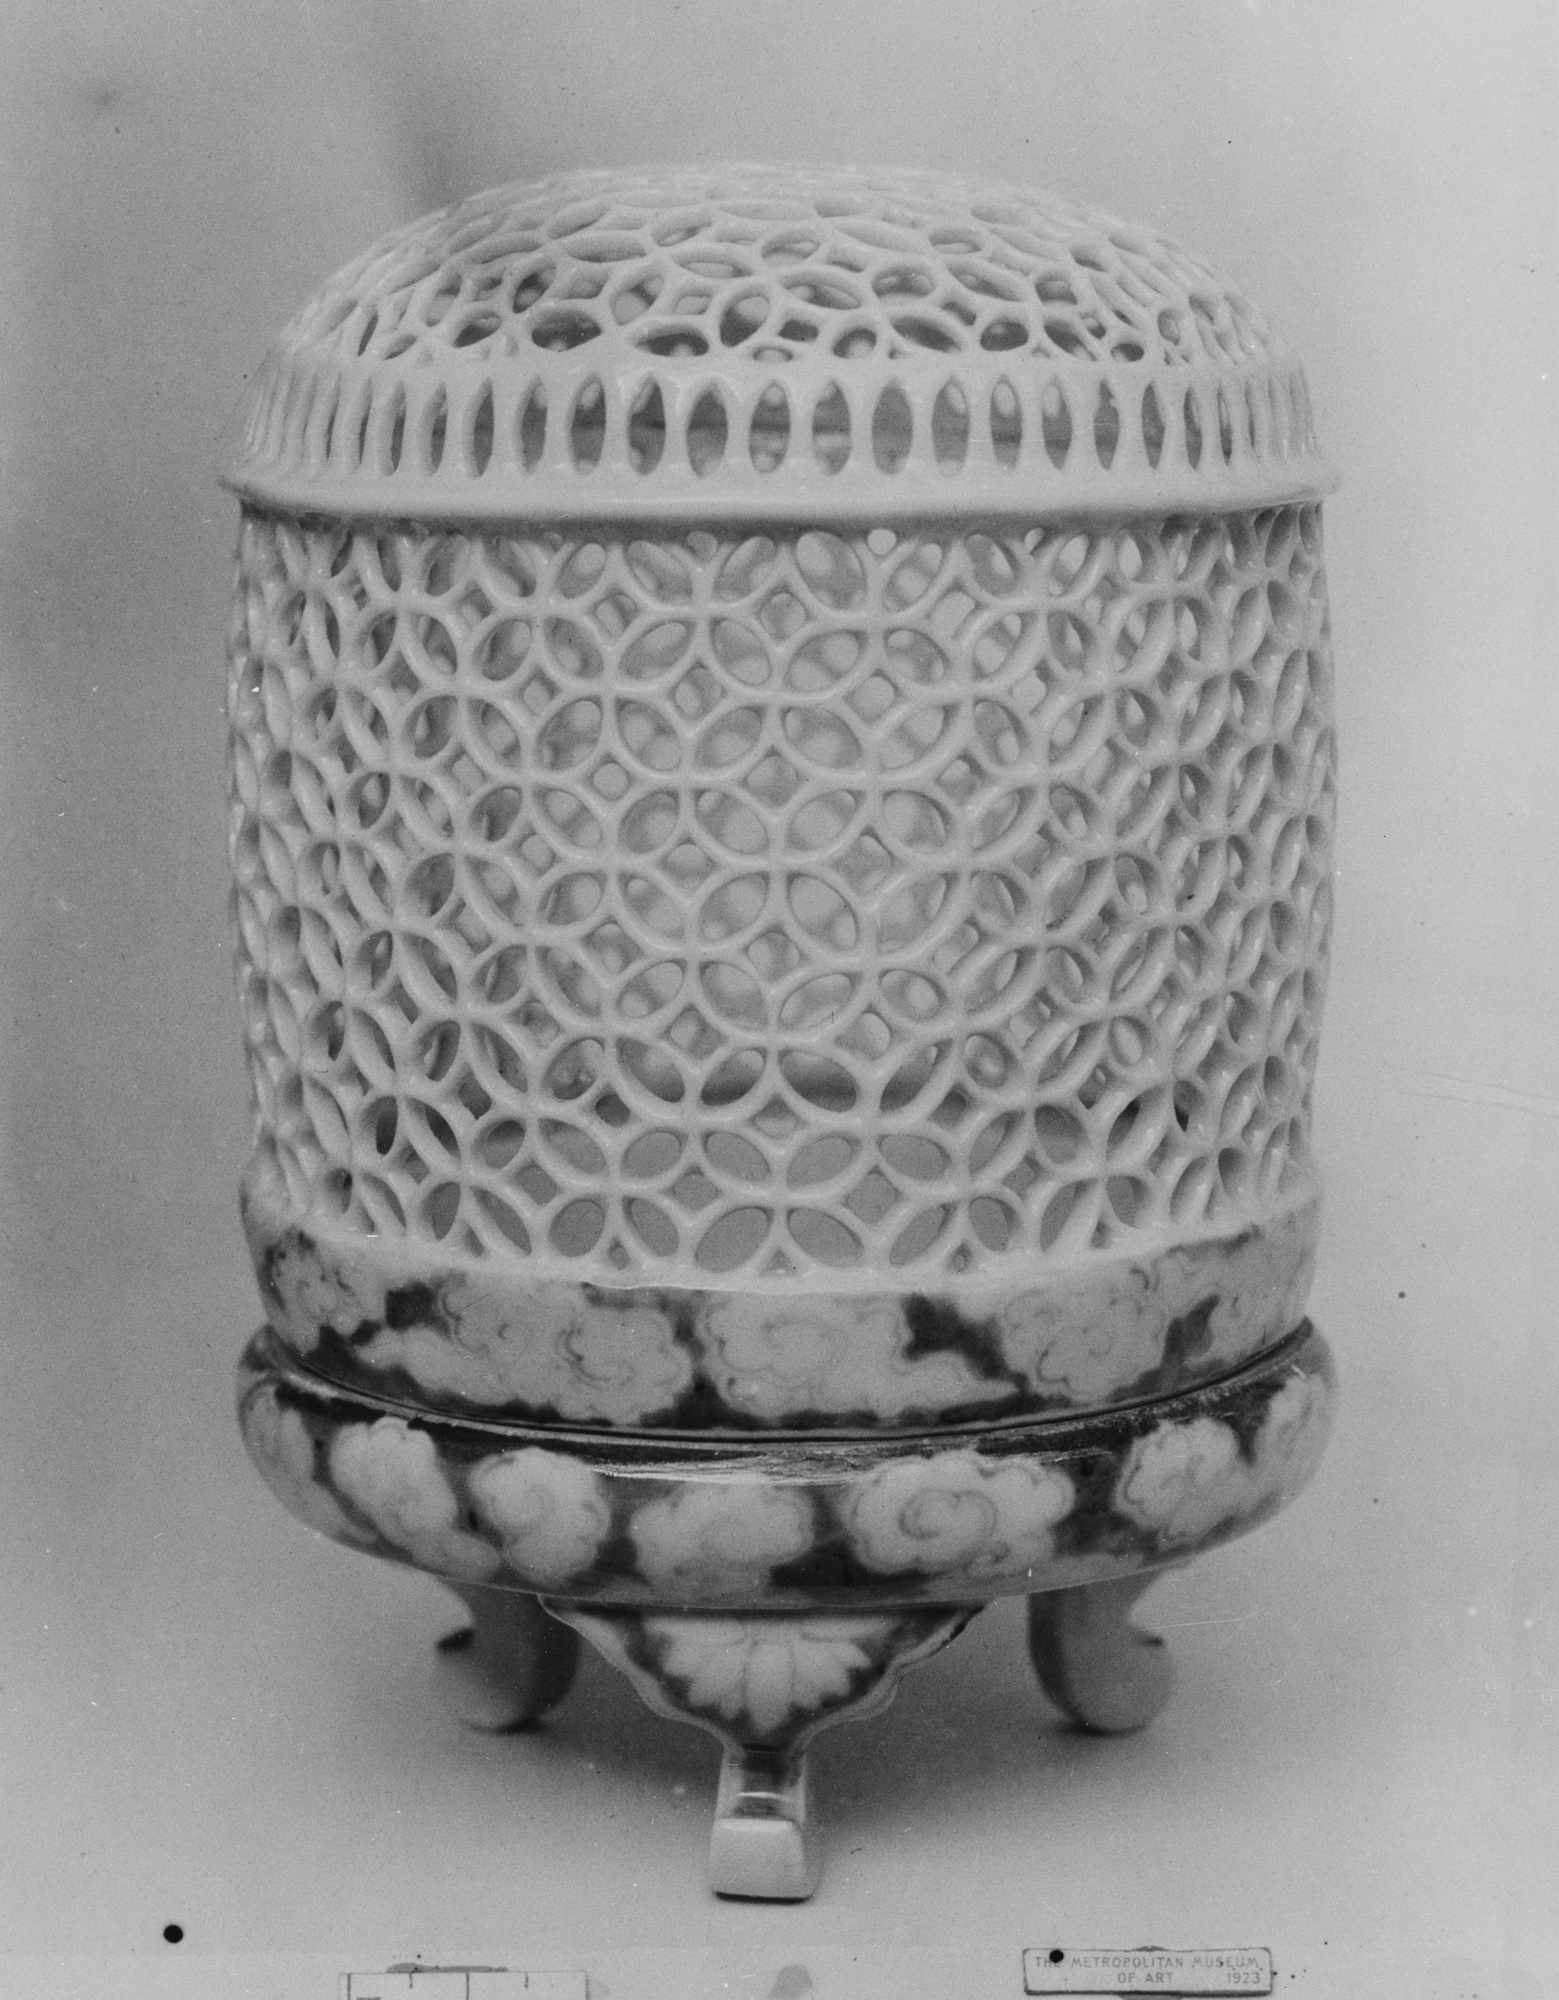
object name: fire fly cage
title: Fire-fly cage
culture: japanese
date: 1840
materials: porcelain